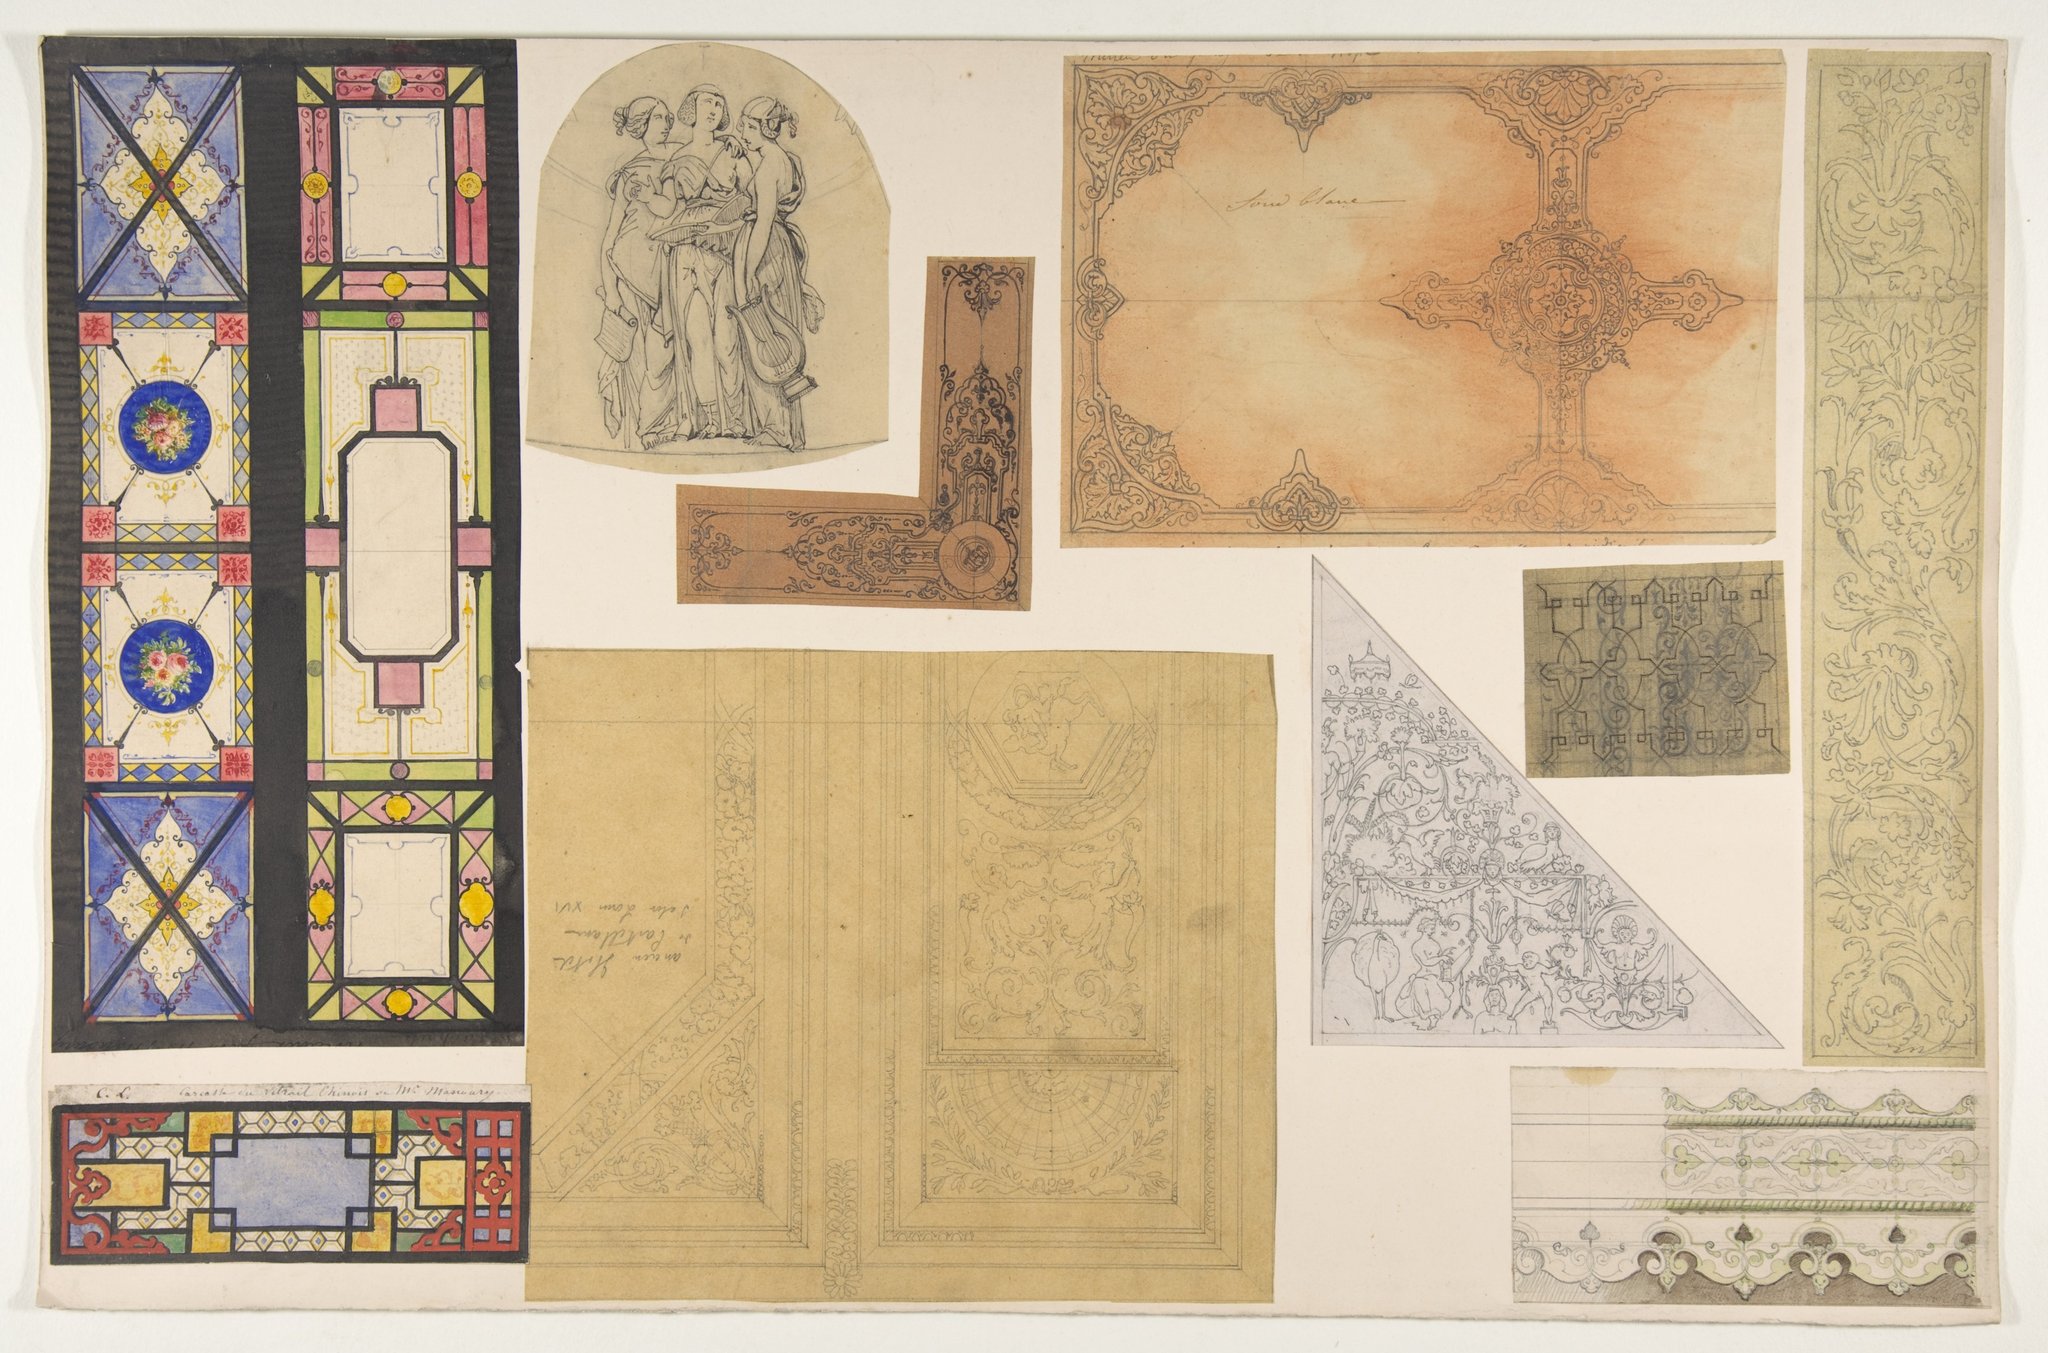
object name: drawing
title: Ten designs for the decoration of the Opéra Comique, Paris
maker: jules-edmond-charles lachaise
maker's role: artist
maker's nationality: french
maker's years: 1897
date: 1851-1900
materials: cardboard, graphite, ink, paper, watercolor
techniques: pen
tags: ornament,women